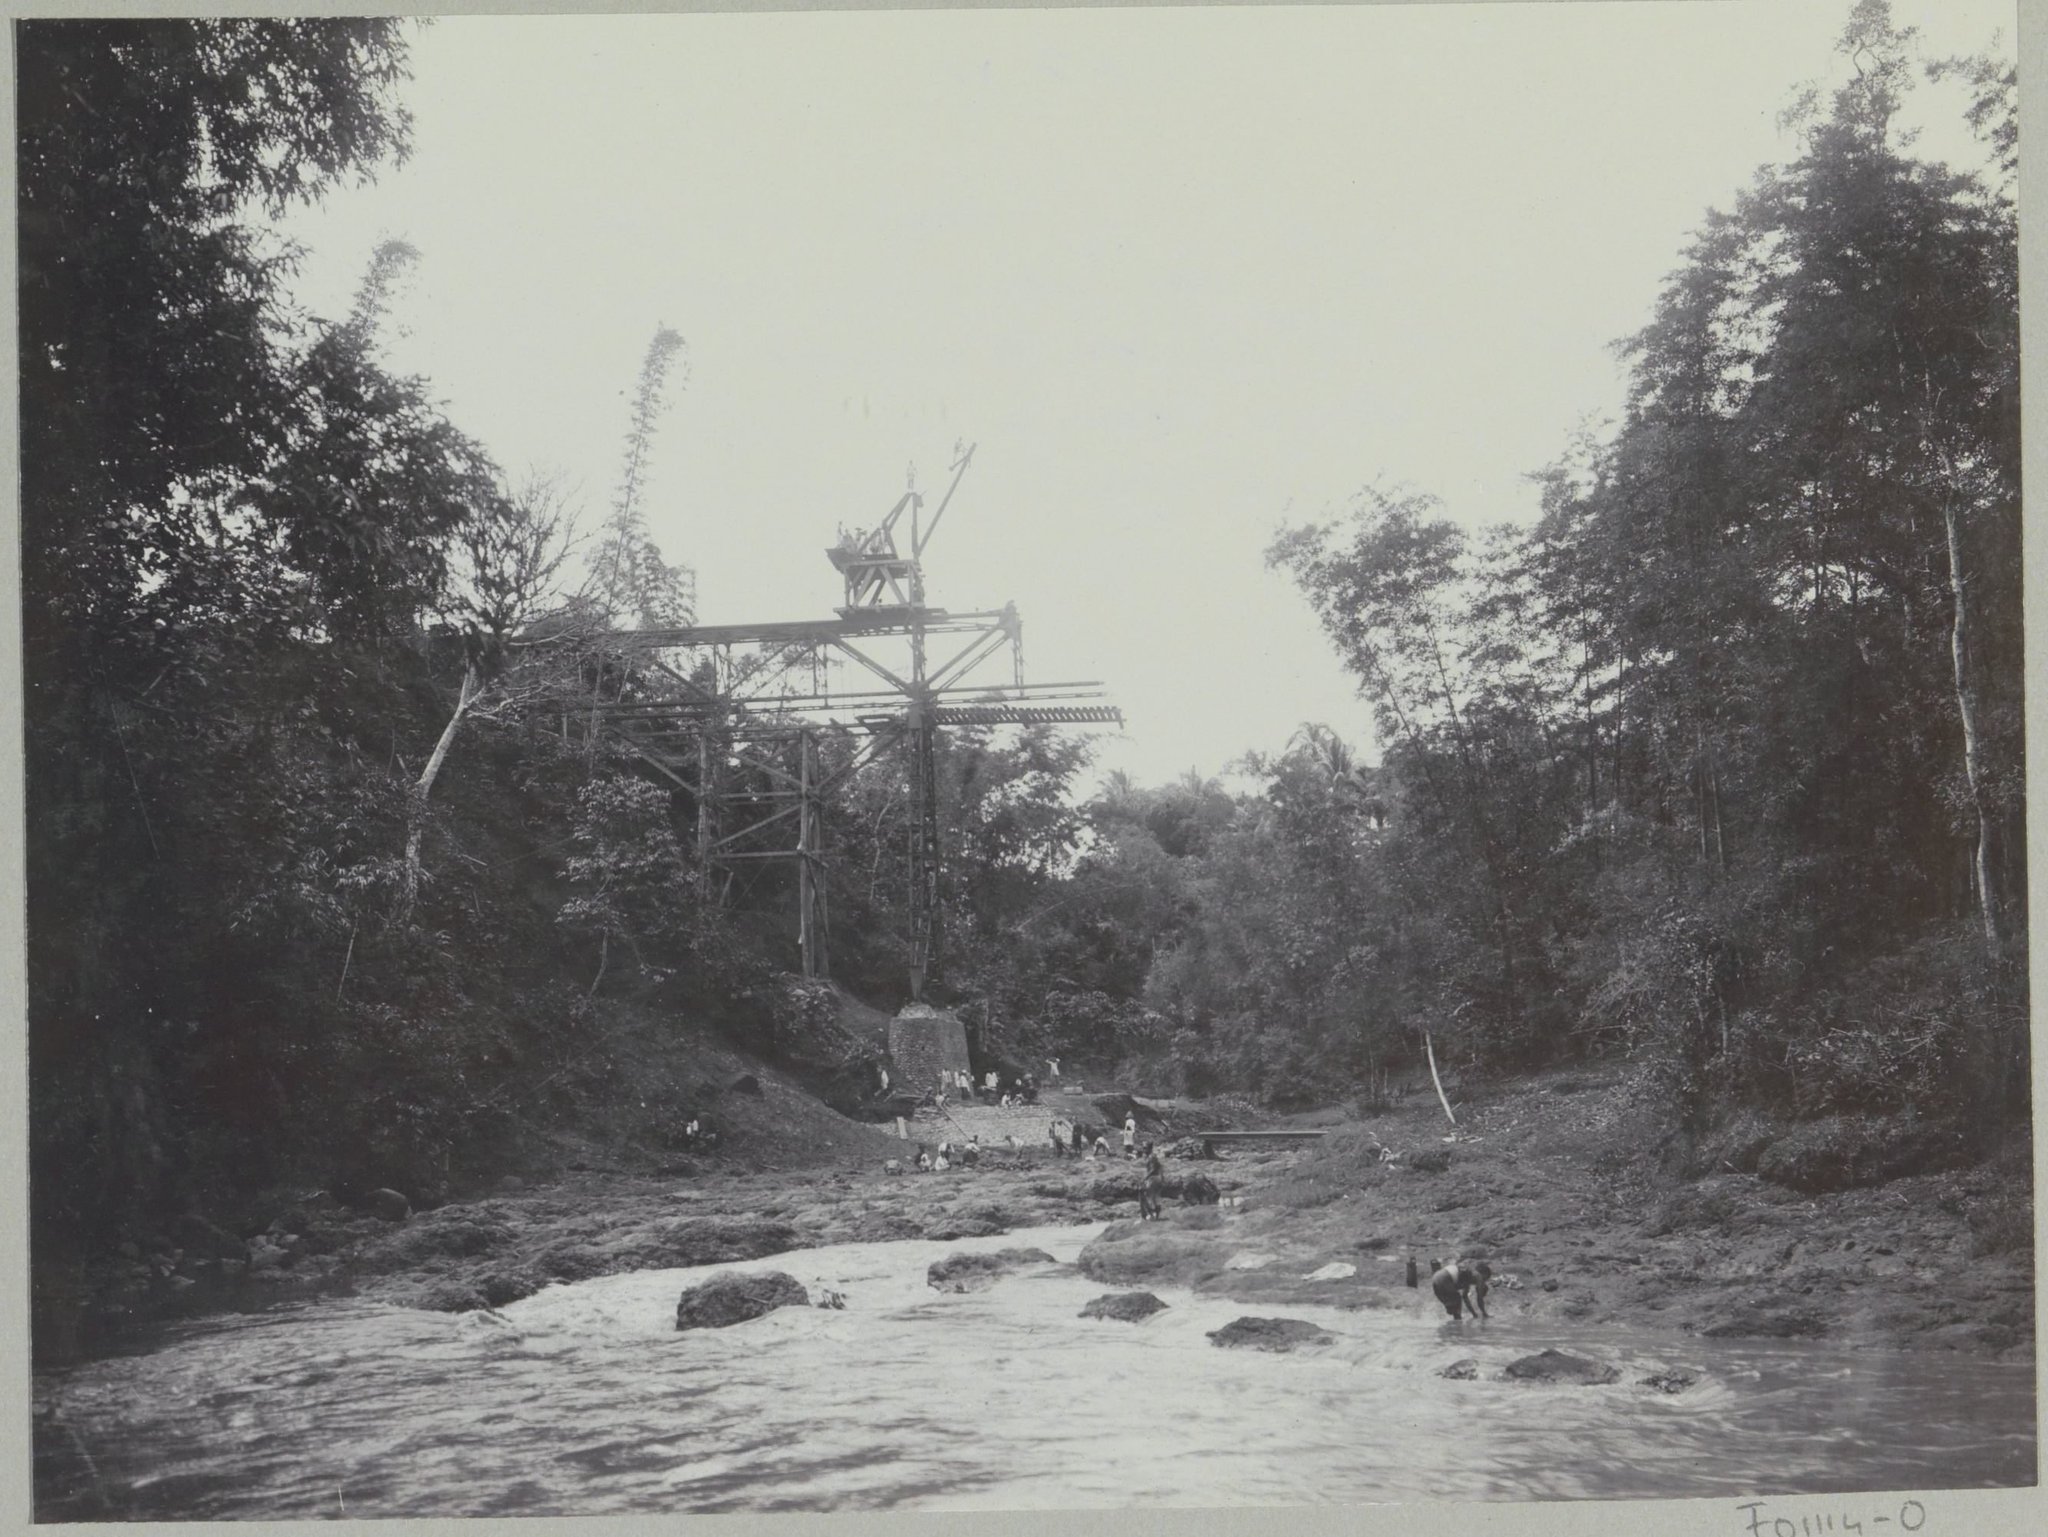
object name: album leaf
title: Bouw van het midddenstuk van een brug op de oostelijke oever van de Kali Brantas ten zuiden van Malang (Photo XV)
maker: Anonymous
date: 1890-1920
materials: cardboard, paper, photographic support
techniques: gelatin silver print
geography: java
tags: engineering, landscape with bridge, viaduct or aqueduct, bridge, building-site, java, dutch east indies, the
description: Foto met op de linkerpagina het bijbehorende bijschrift. Onderdeel van Fotoalbum met opnames van de bouw van een brug over de Kali Brantas ten zuiden van Malang op Java.